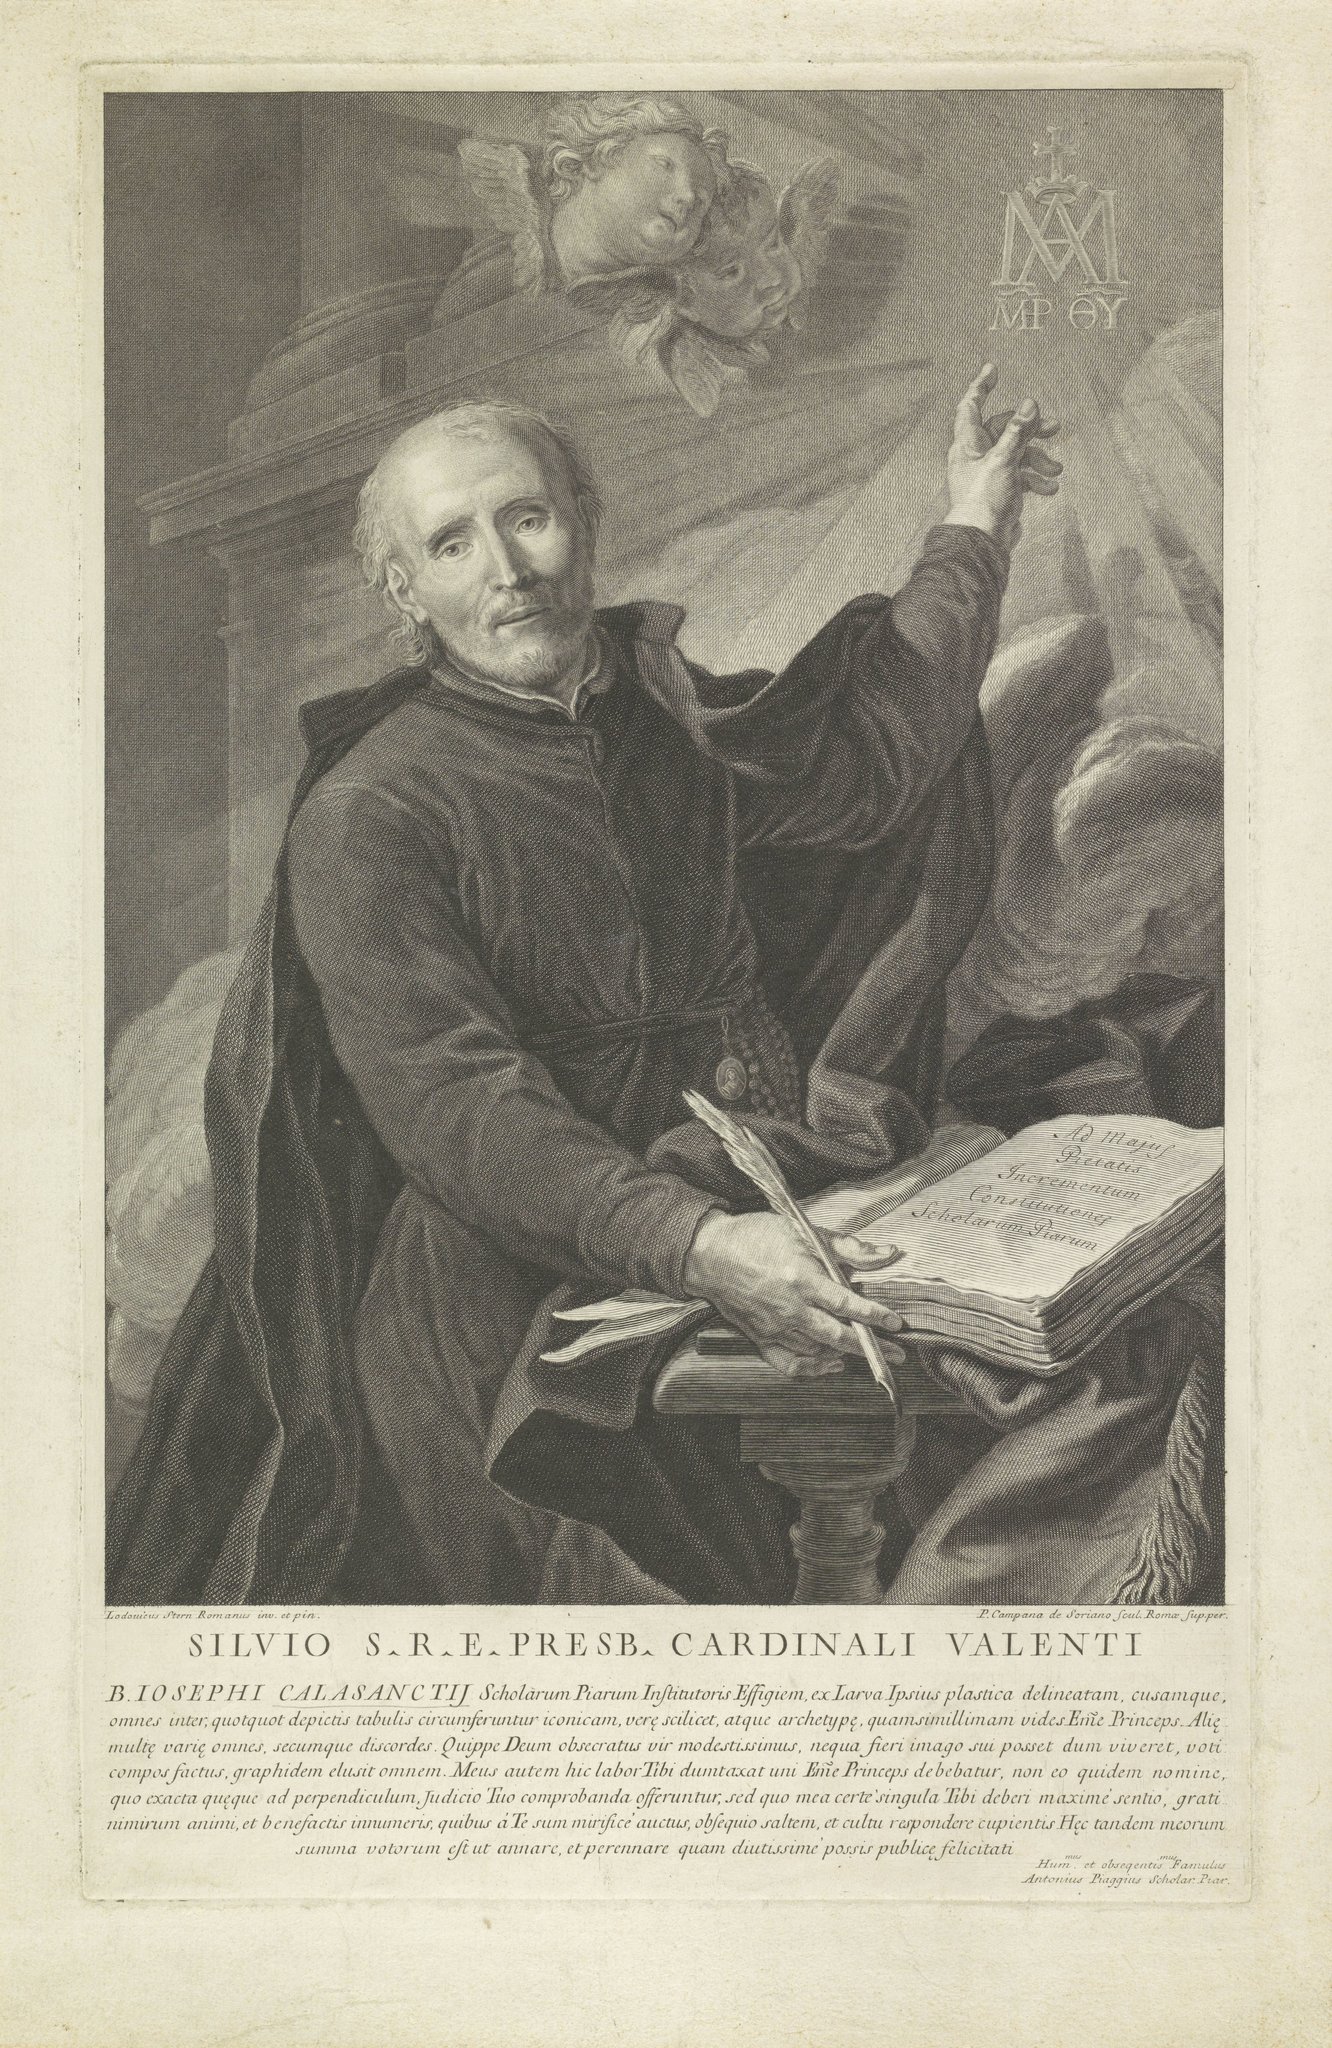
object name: print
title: Portret van de geestelijke B. Josephi Calasanctij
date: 1735-1779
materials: paper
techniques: engraving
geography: rome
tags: historical persons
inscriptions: collector's mark: Lugt 2228